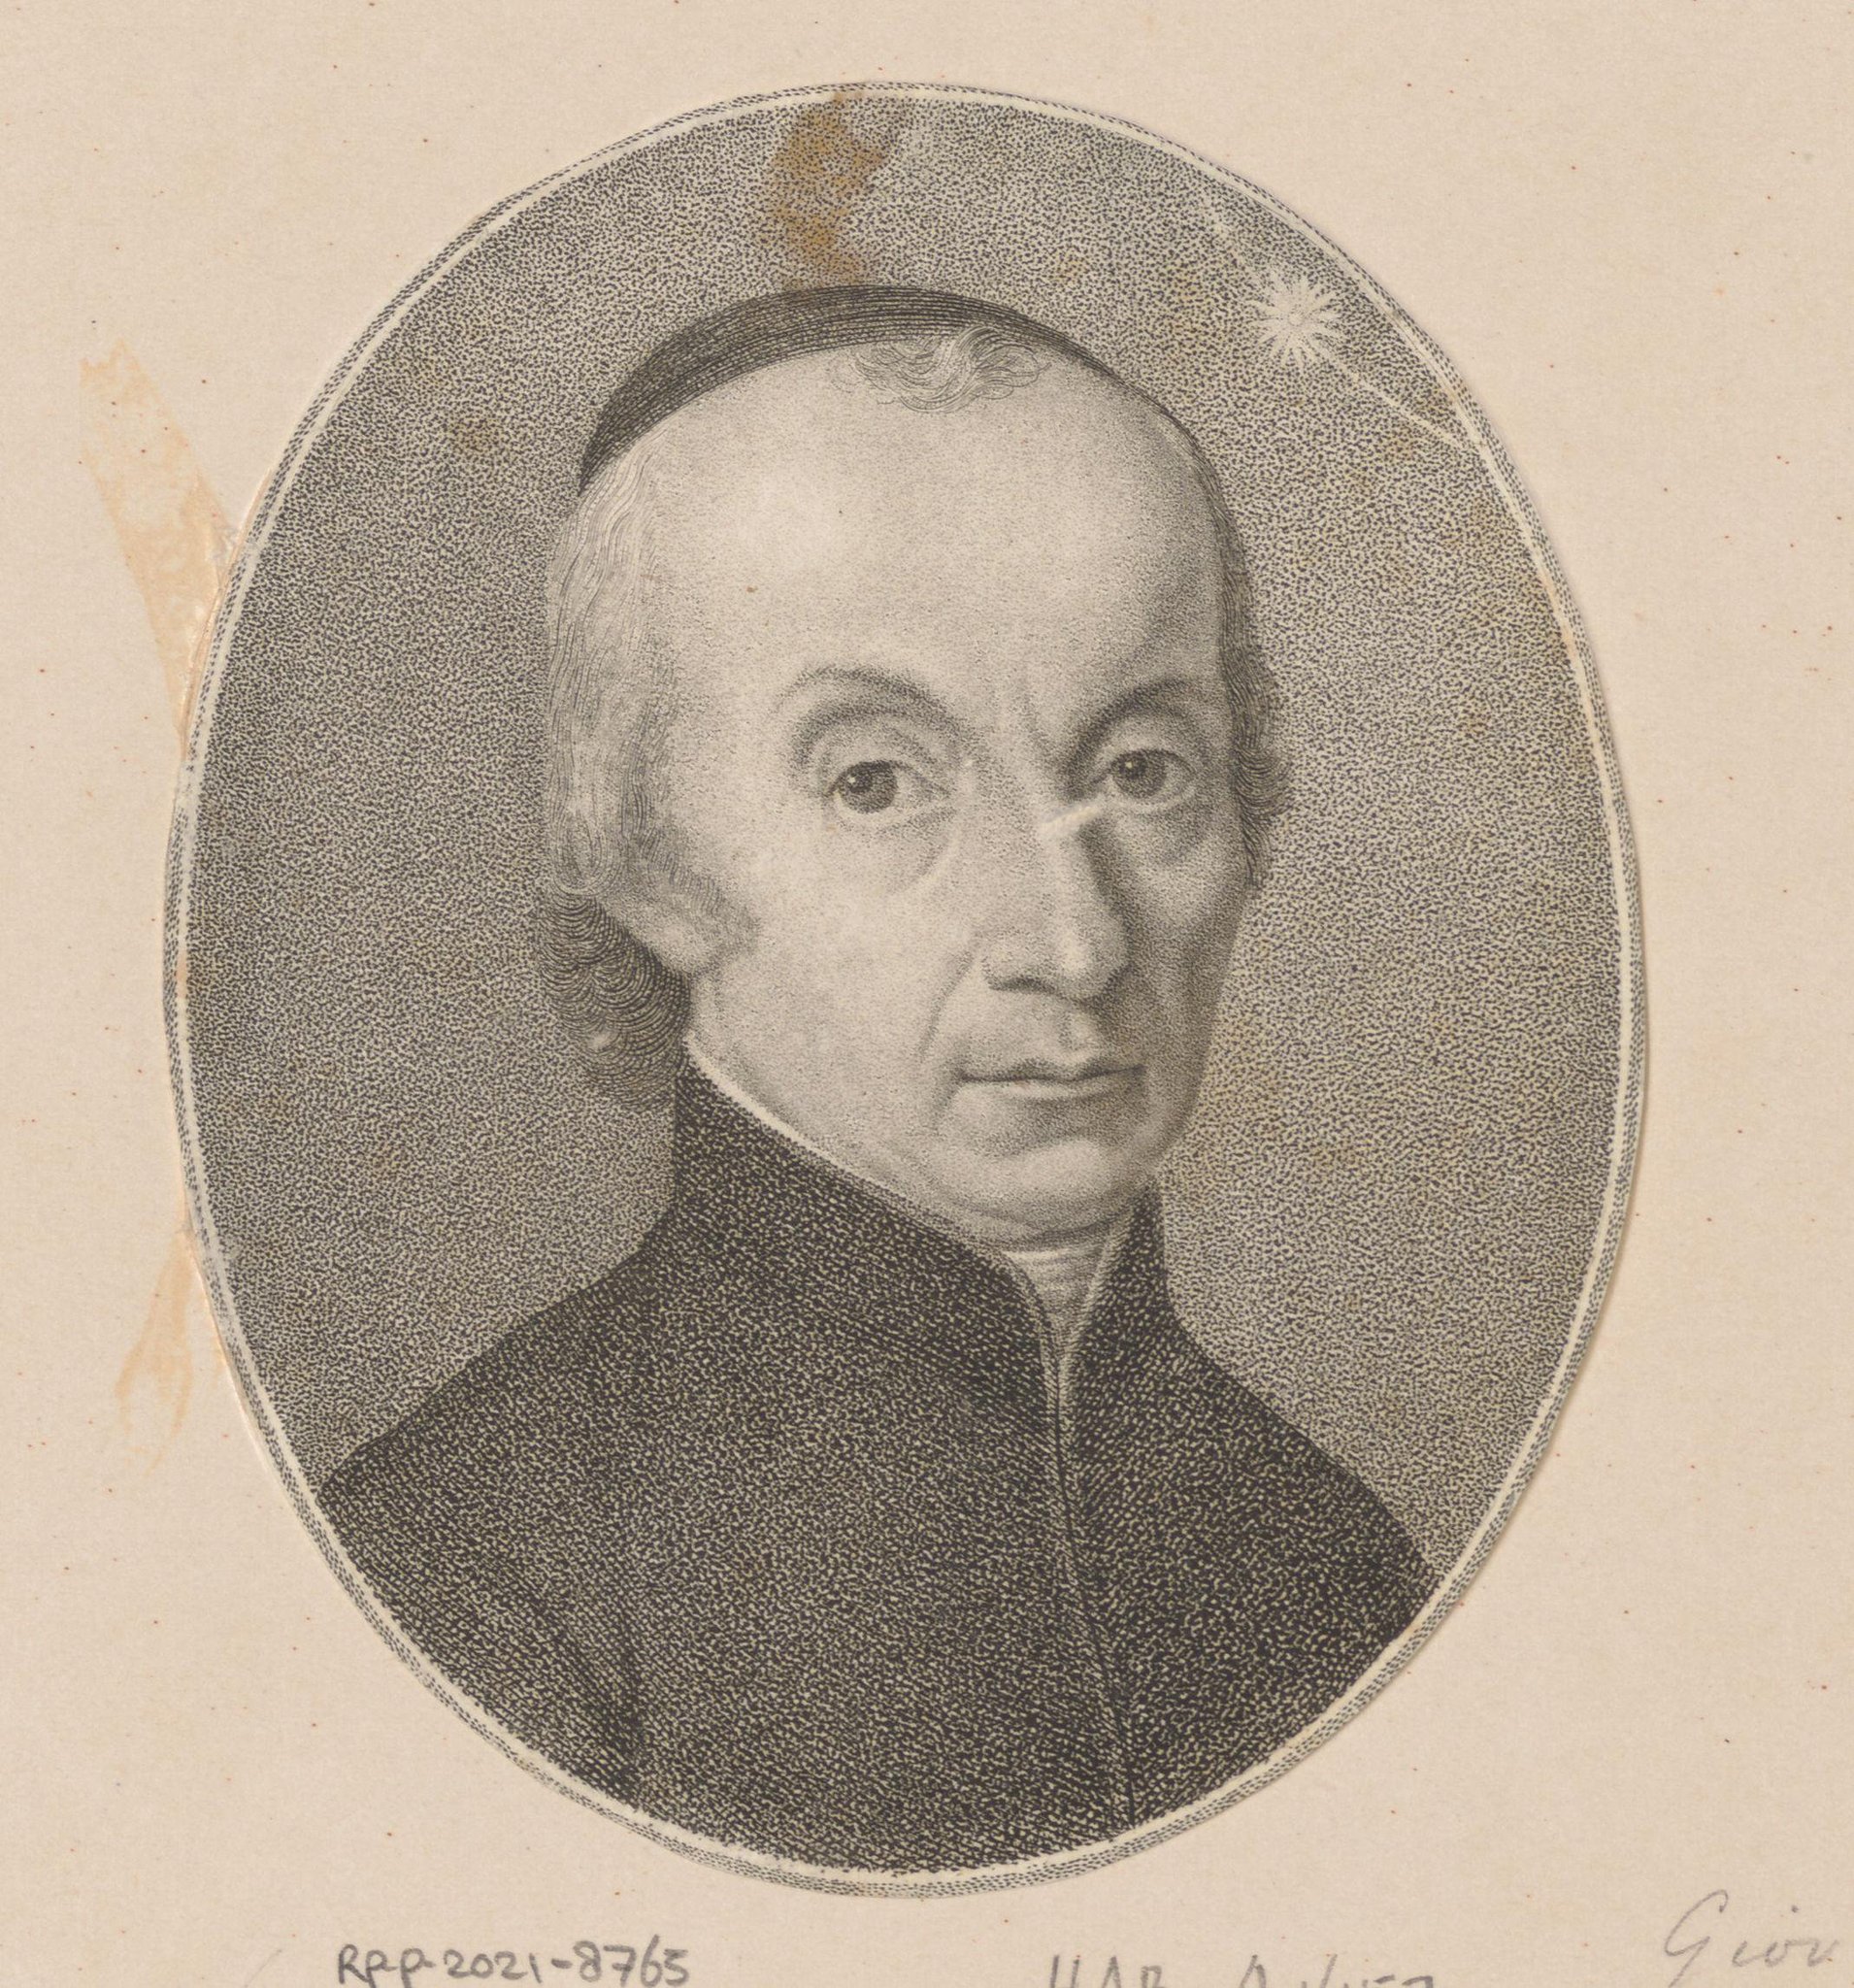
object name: print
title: Portret van Giuseppe Piazzi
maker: benedetto bordiga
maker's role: print maker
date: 1808-1810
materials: paper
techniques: engraving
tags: adult man, historical persons, astronomical phenomena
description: Prent mogelijk uit: Zach, Franz Xaver von. Monatliche Correspondenz zur Beförderung der Erd- und Himmelskunde. Gotha: Becker, 1810, dl. 21.